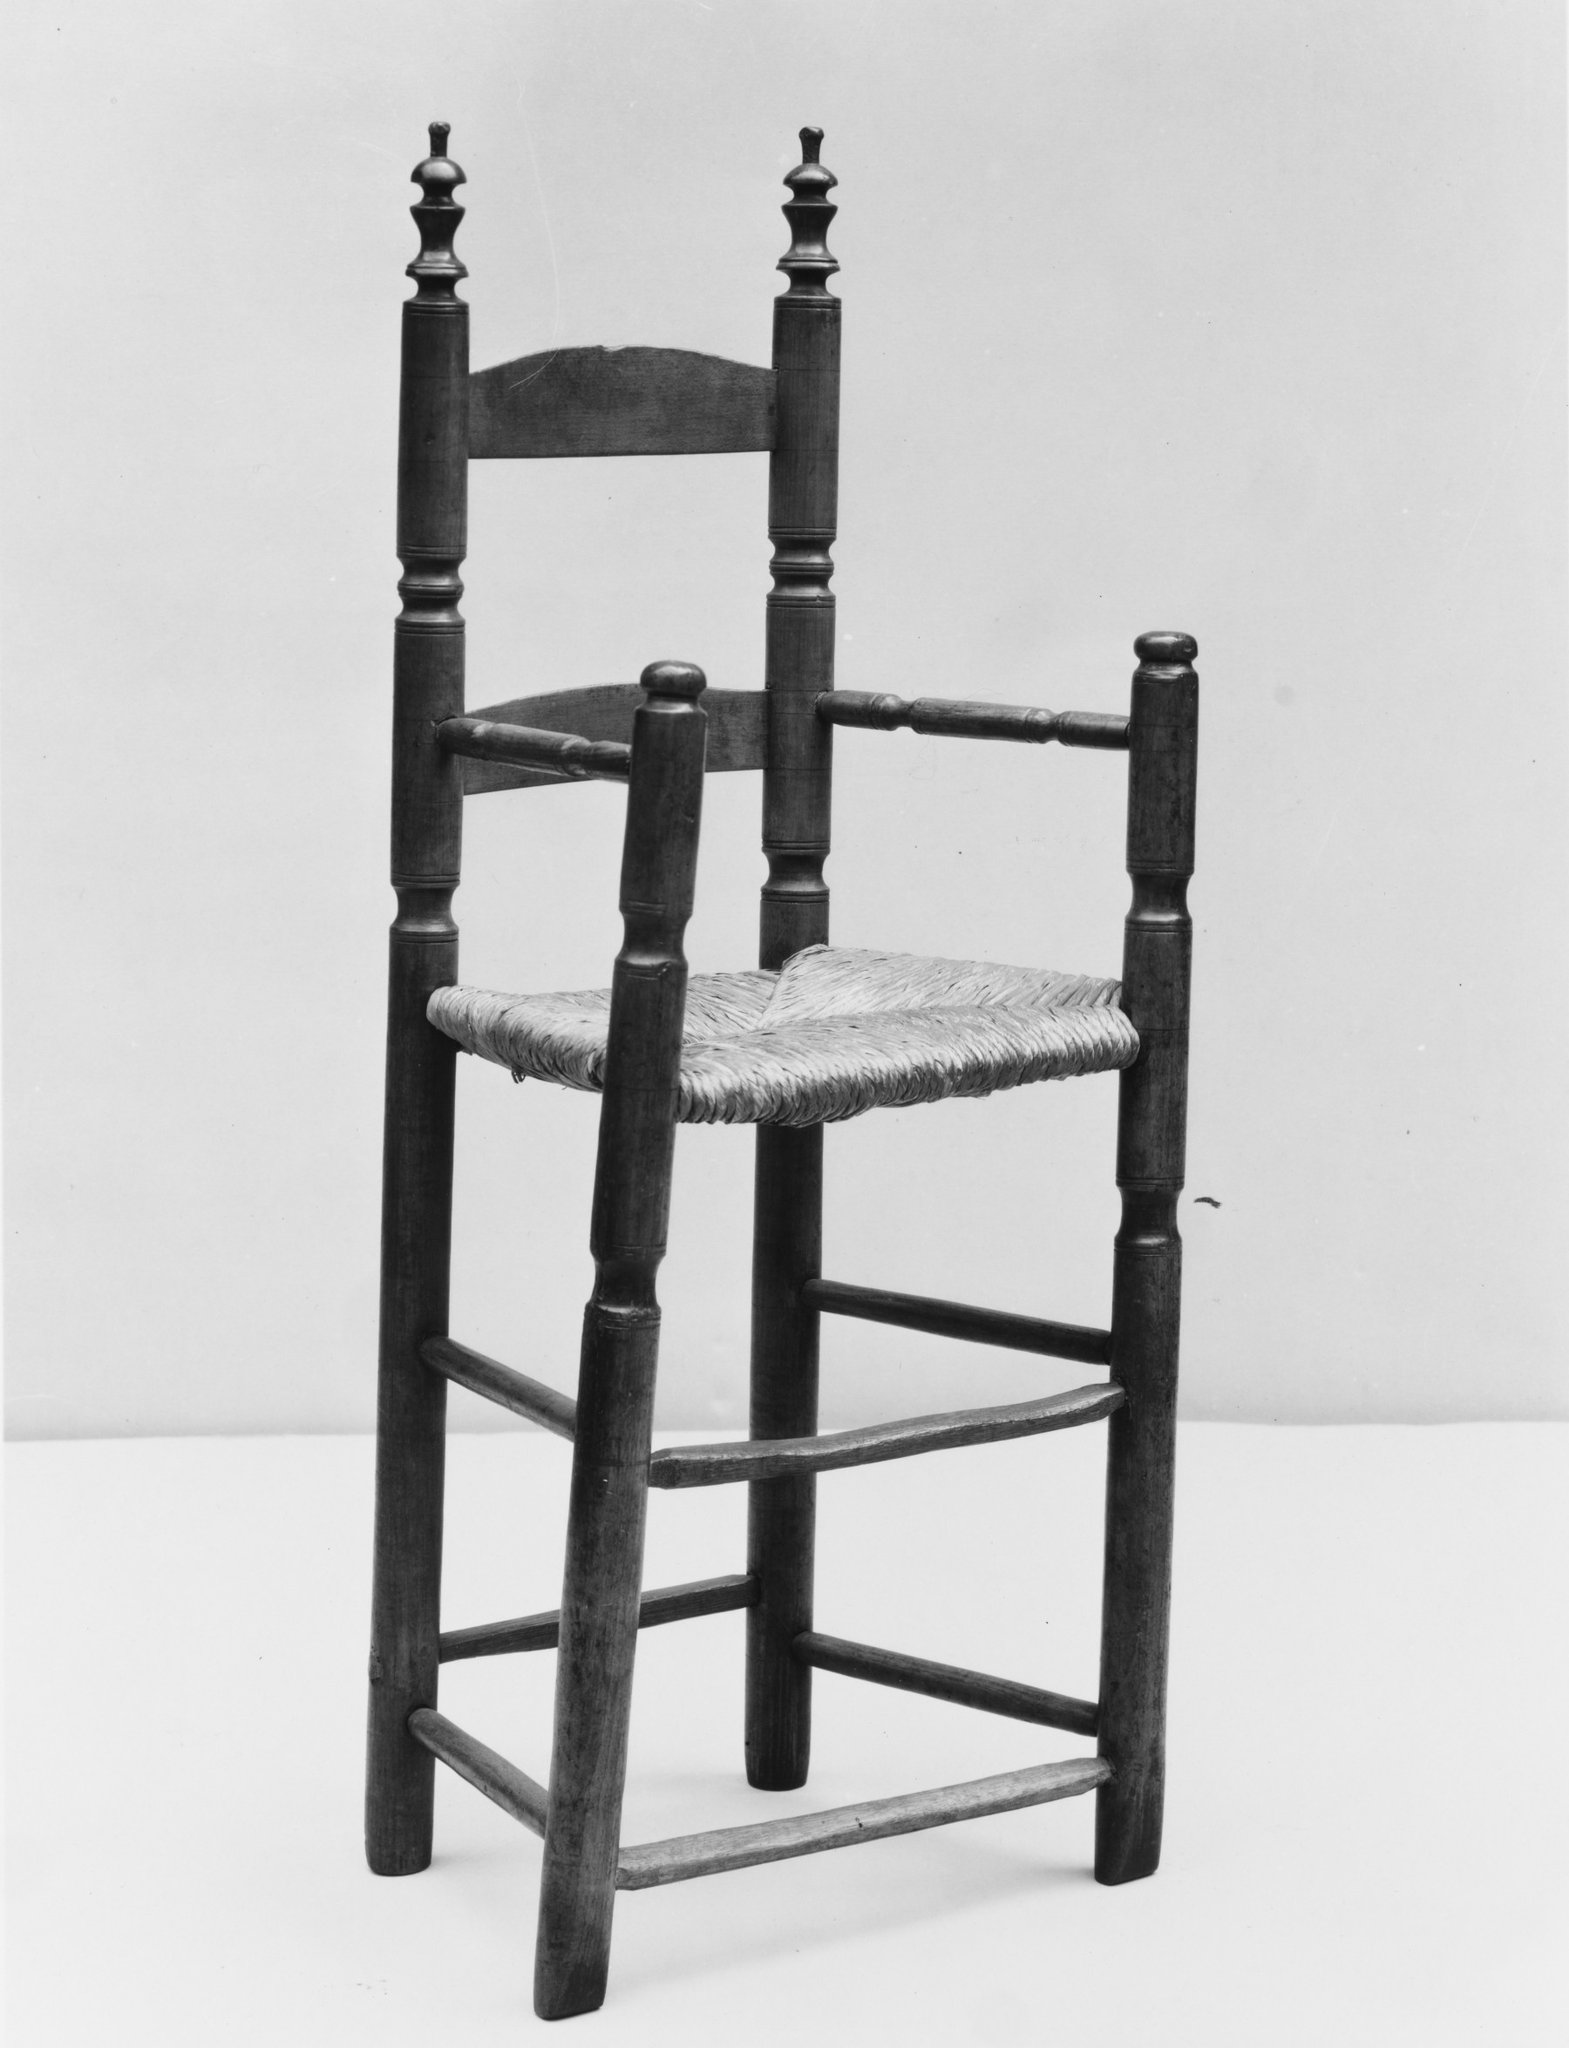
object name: high chair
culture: american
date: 1700-1800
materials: wood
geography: united states